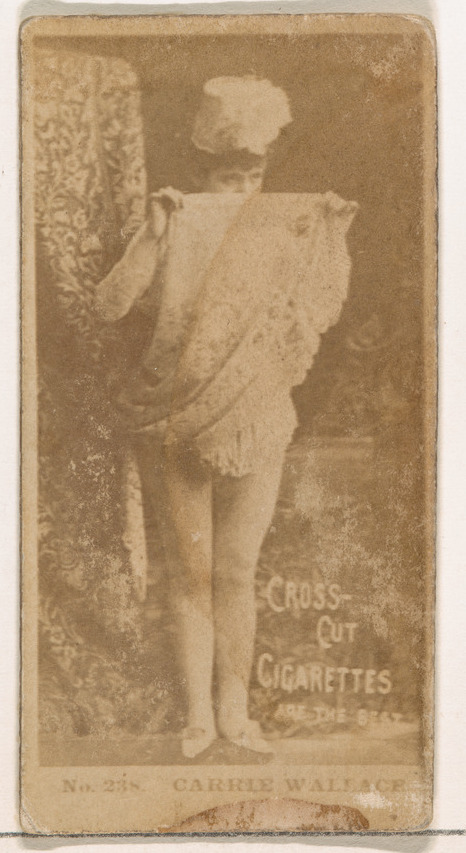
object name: print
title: Card Number 238, Carrie Wallace, from the Actors and Actresses series (N145-2) issued by Duke Sons & Co. to promote Cross Cut Cigarettes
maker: w. duke, sons & co.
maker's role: publisher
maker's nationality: american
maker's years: 1870-1920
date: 1880-1889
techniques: albumen silver print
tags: portraits,women,actresses